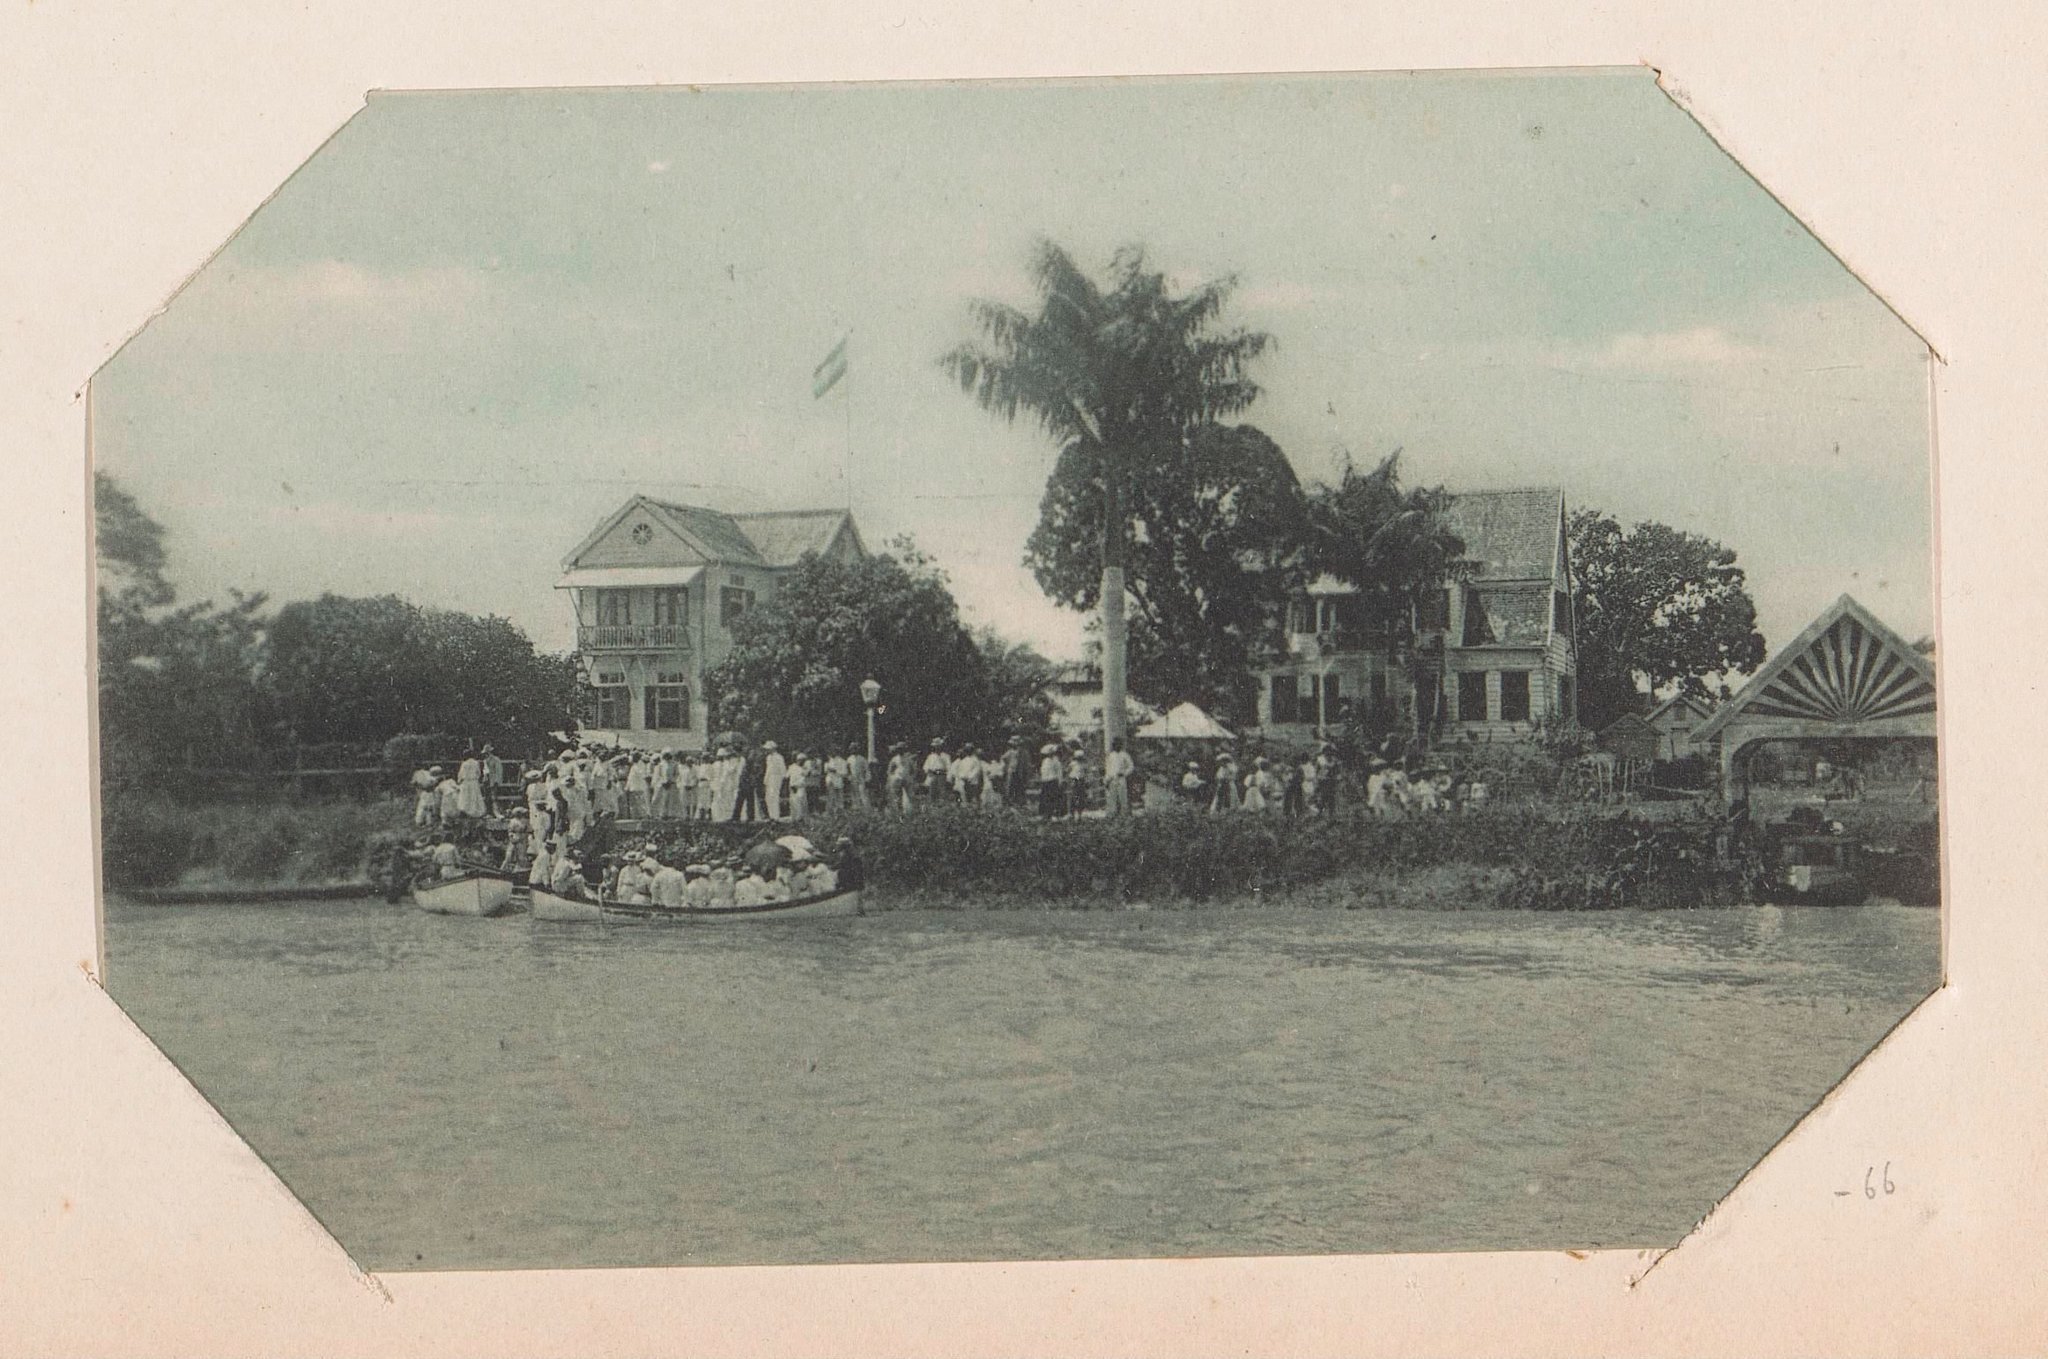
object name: ansichtkaart, prentbriefkaart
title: Een bezoek op Bethesda (Groot Chatillon)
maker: Anonymous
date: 1900-1910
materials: cardboard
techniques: photograph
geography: paramaribo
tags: leprosarium, river (+ landscape with figures, staffage), suriname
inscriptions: serial number: ‘No. 116. Uitgevers C. Kersten & Co., Paramaribo’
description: Grote groep mensen op een rivieroever bij Bethesda. Meer mensen arriveren per sloep. Bethesda was de leprozenkolonie gesticht door de Evangelische Broeder Gemeente. Onderdeel van een verzameling van 68 briefkaarten uit Suriname, bijeengebracht in een album als aandenken aan een verblijf in Suriname in september 1911.